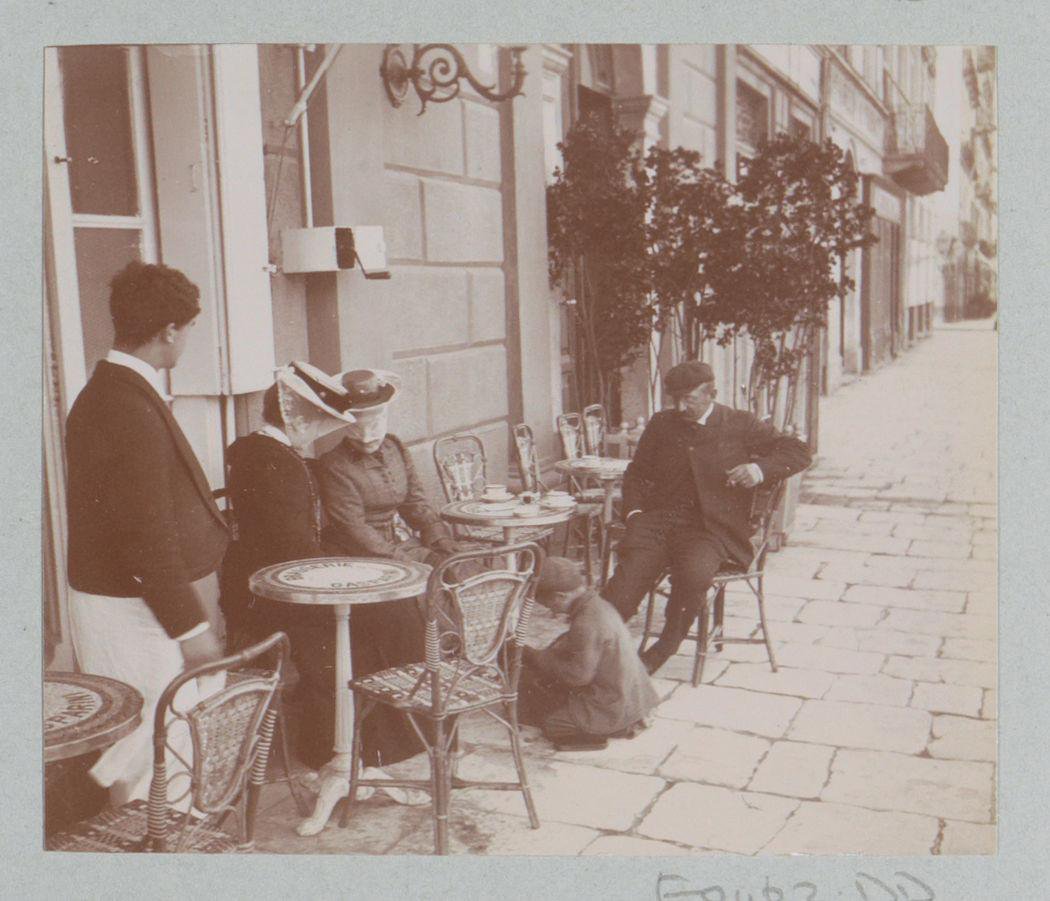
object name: photograph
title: Gezelschap op het terras van Brasserie Gasparini op Corsica, met een ober en vermoedelijk een schoenpoetser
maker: Anonymous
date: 1905-1910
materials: paper, photographic support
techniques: gelatin silver print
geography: bastia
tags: cleaning of material, inn, coffee-house, public house, etc., pavement, terrace in front of inn or restaurant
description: Onderdeel van Fotoalbum van een Franse amateurfotograaf met bezienswaardigheden in Frankrijk, Zwitserland en Italië.